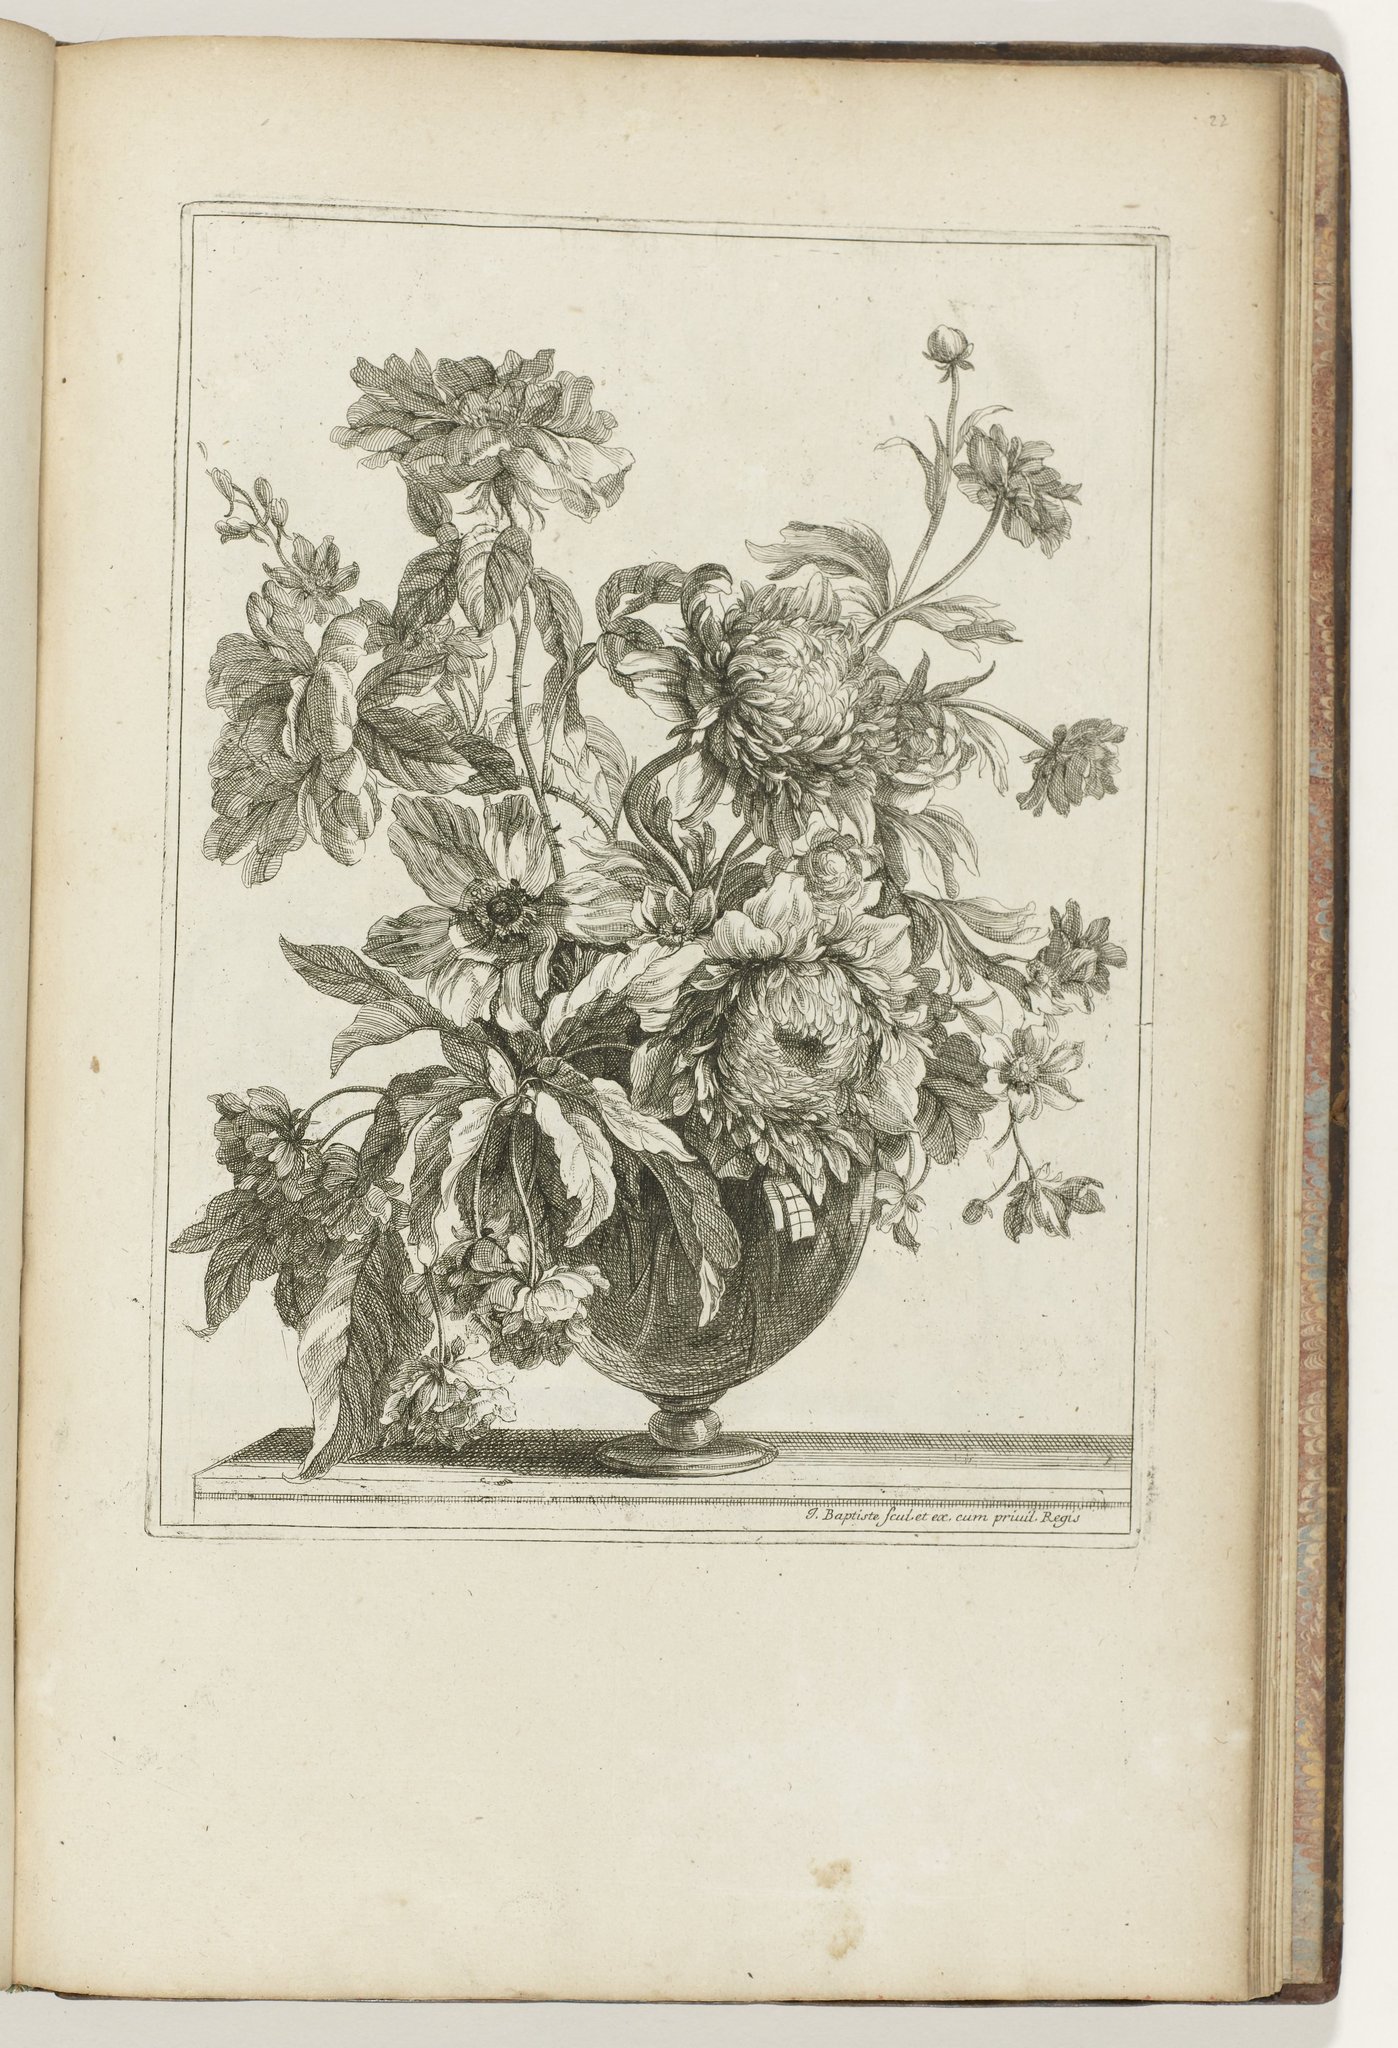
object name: print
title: Les Vases Diaphanes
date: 1680-1695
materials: paper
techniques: etching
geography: paris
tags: flowers in a vase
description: Boeket in glazen vaas. Prent maakt deel uit van een album.